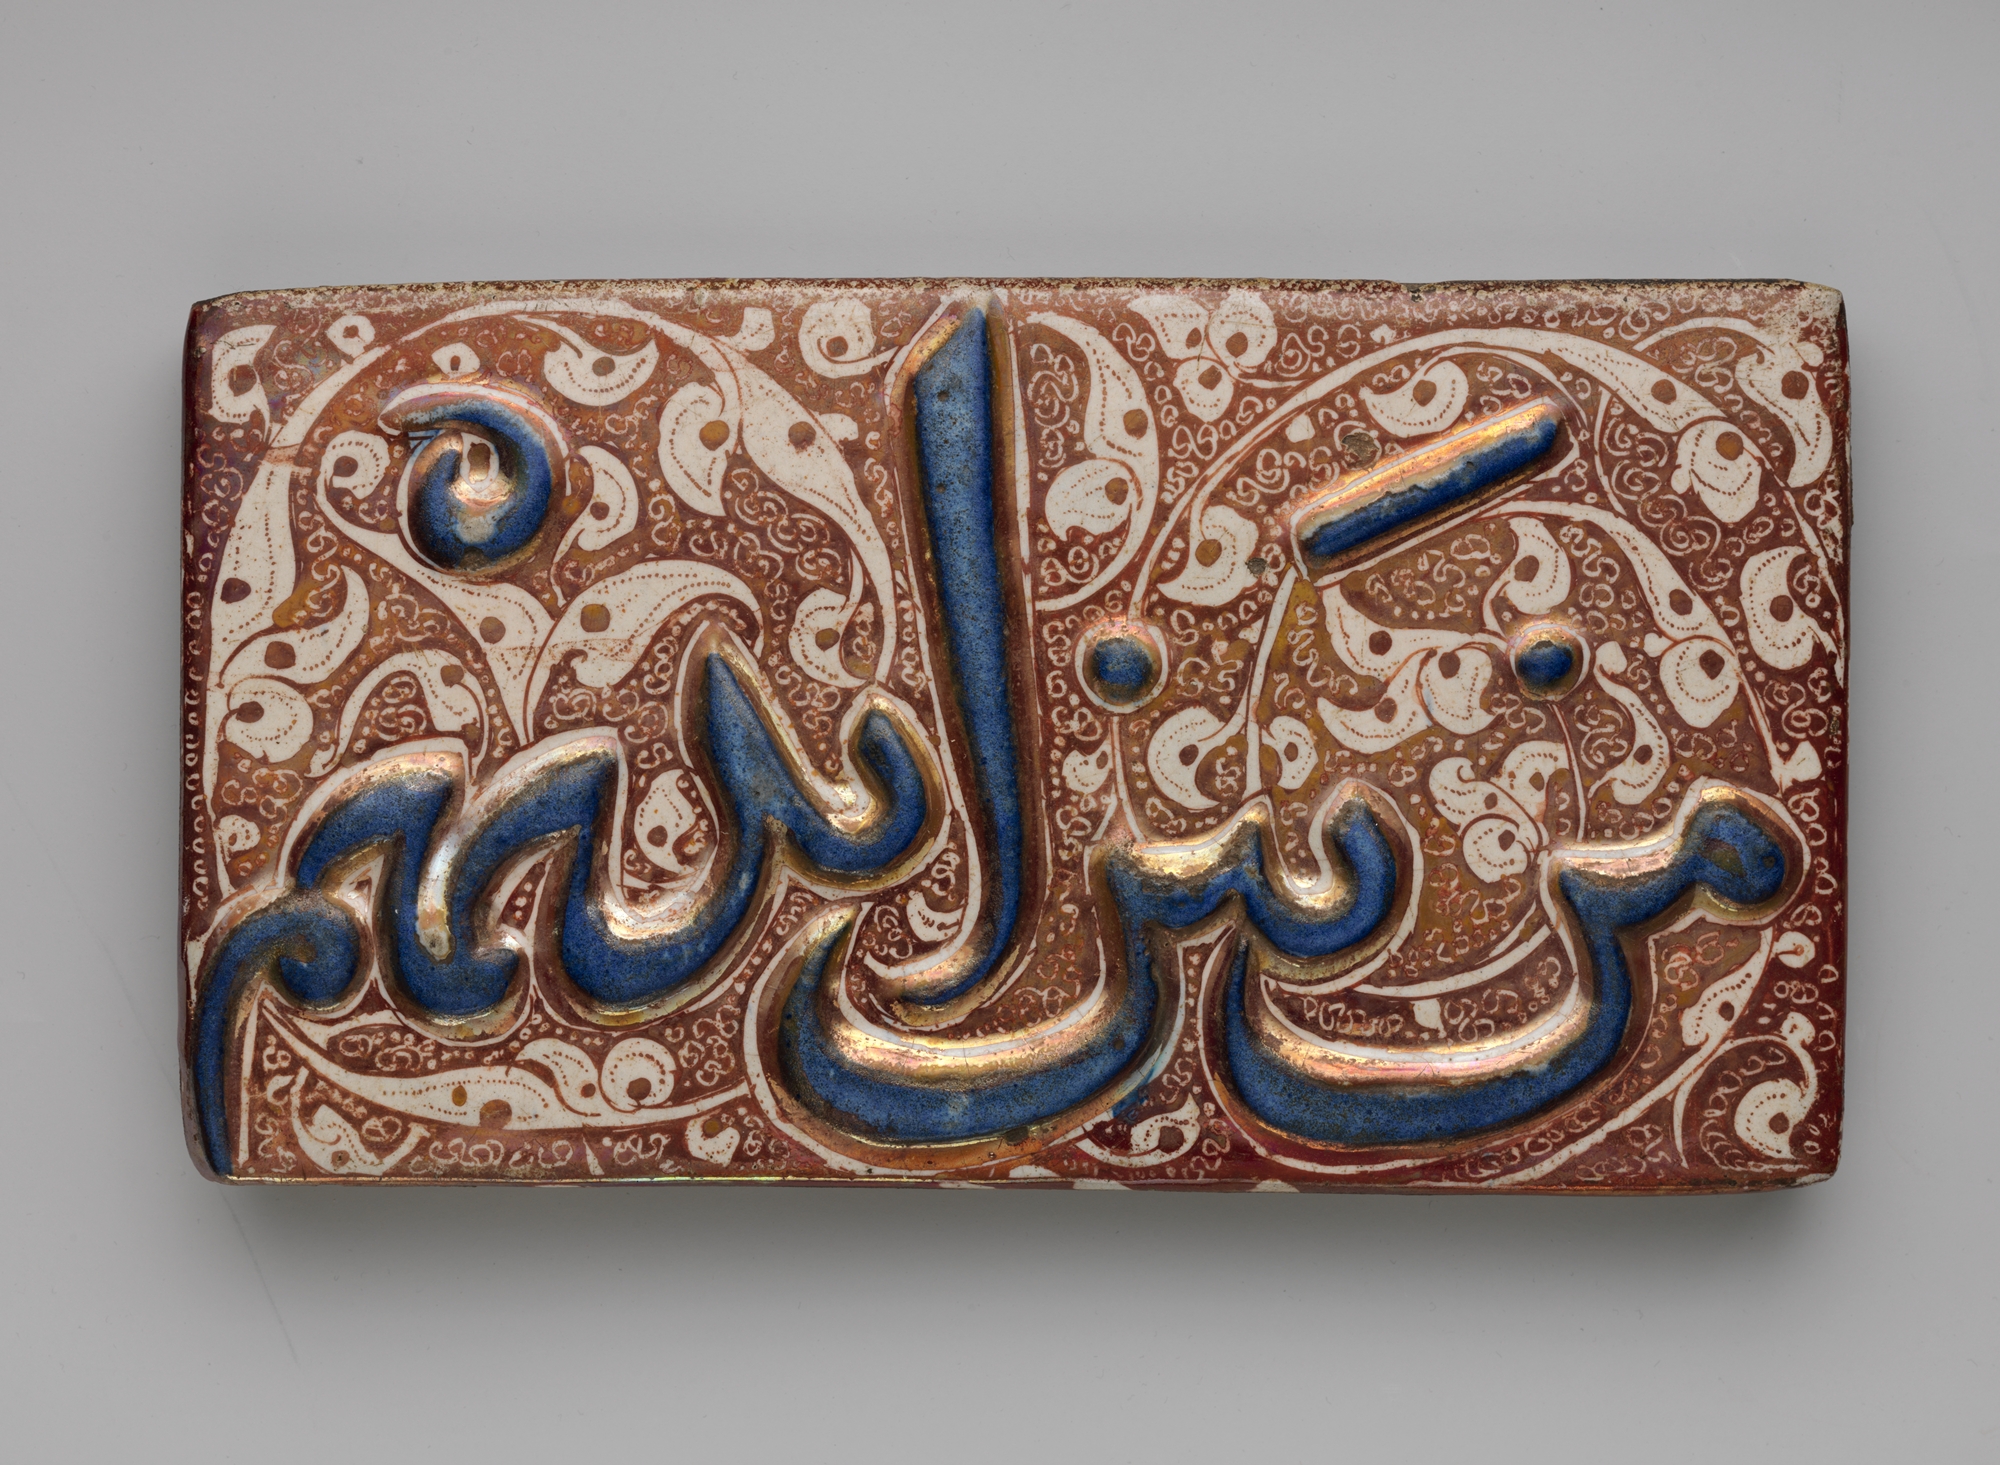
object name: tile panel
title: Pair of Tiles with Qur'anic Inscription from Sura 36 (Ya-Sin): 9 and 15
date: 1251-1300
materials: glaze, stonepaste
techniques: luster painting, molding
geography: iran